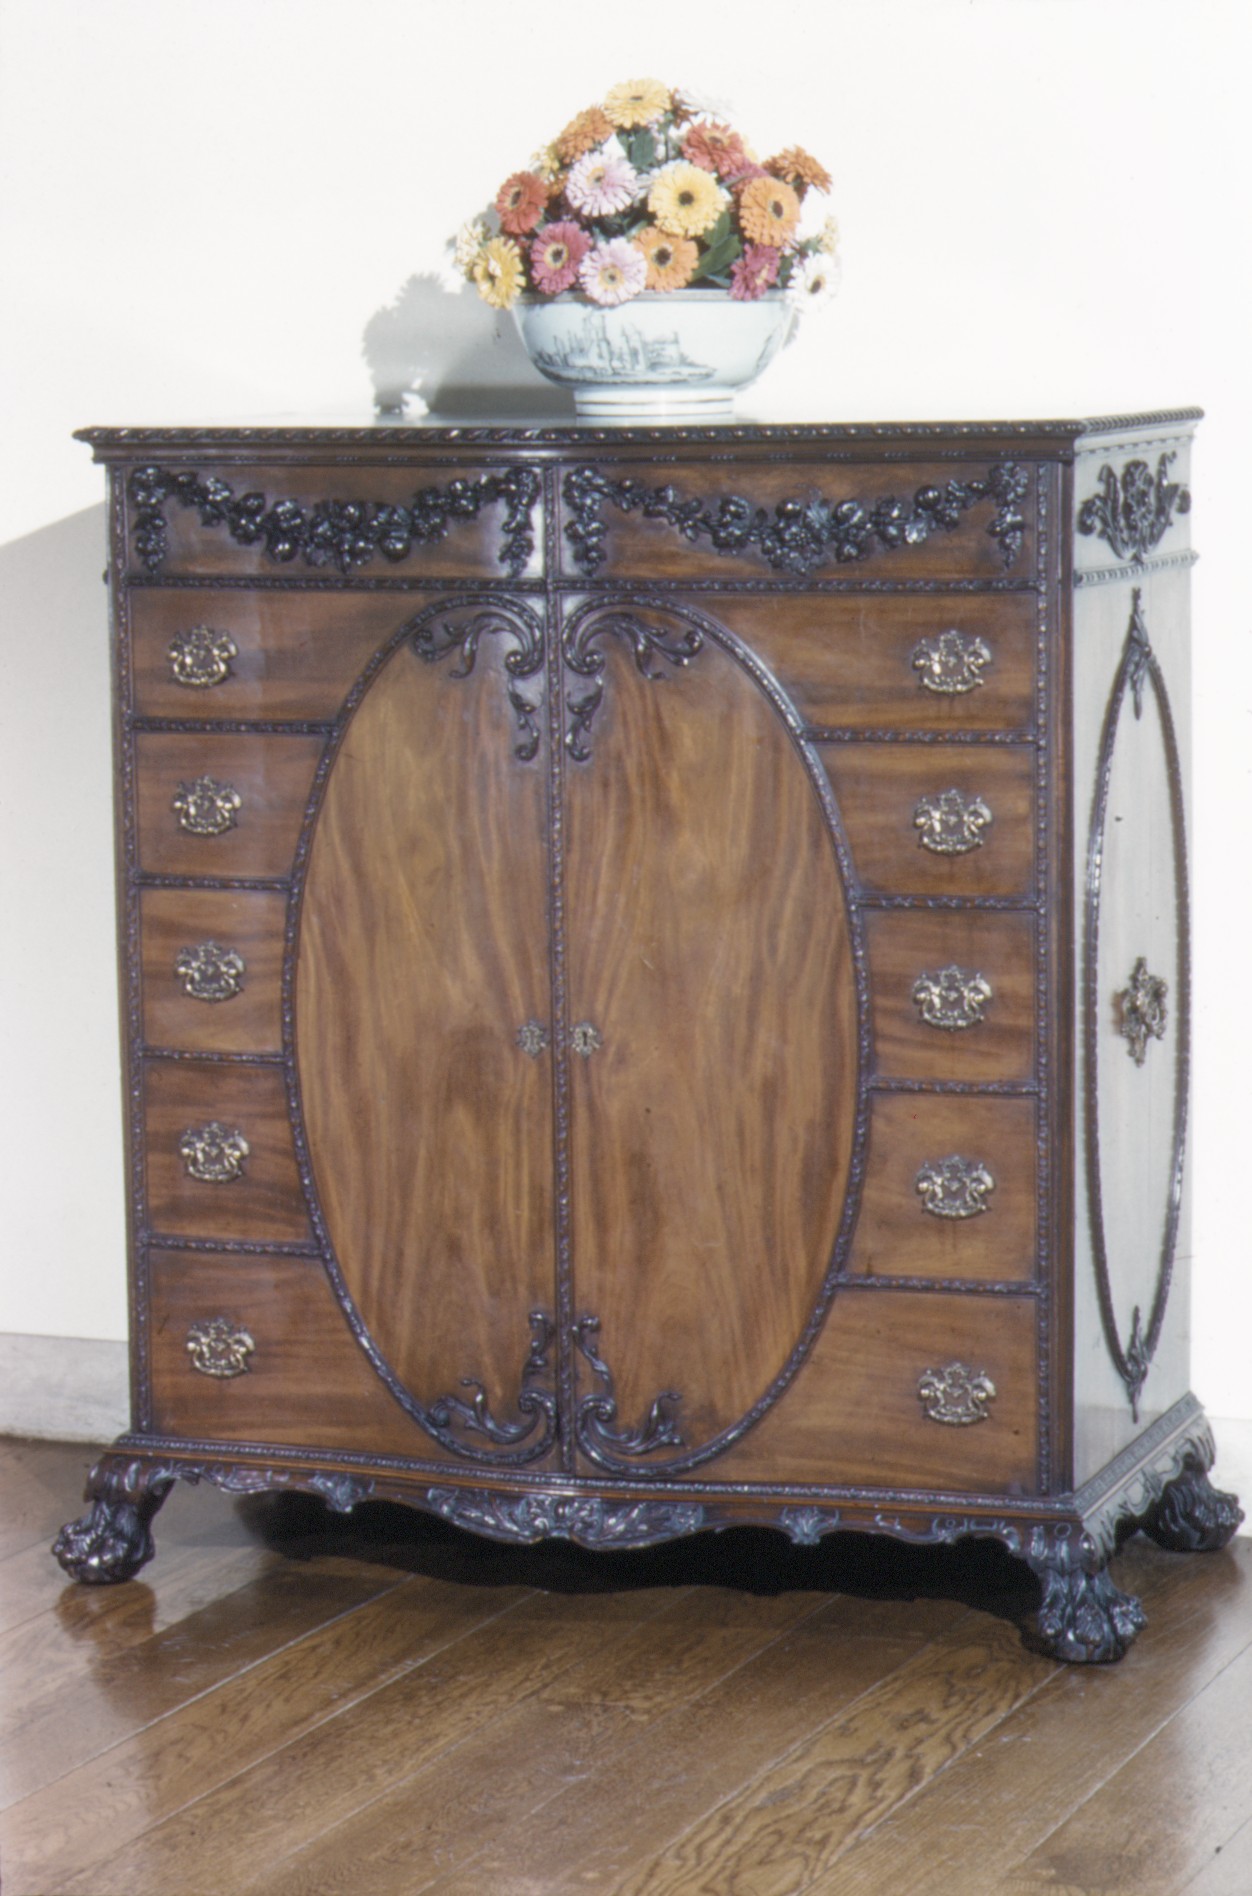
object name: clothes press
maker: william vile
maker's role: maker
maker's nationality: british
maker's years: 1715-1767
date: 1760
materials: wood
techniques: veneering